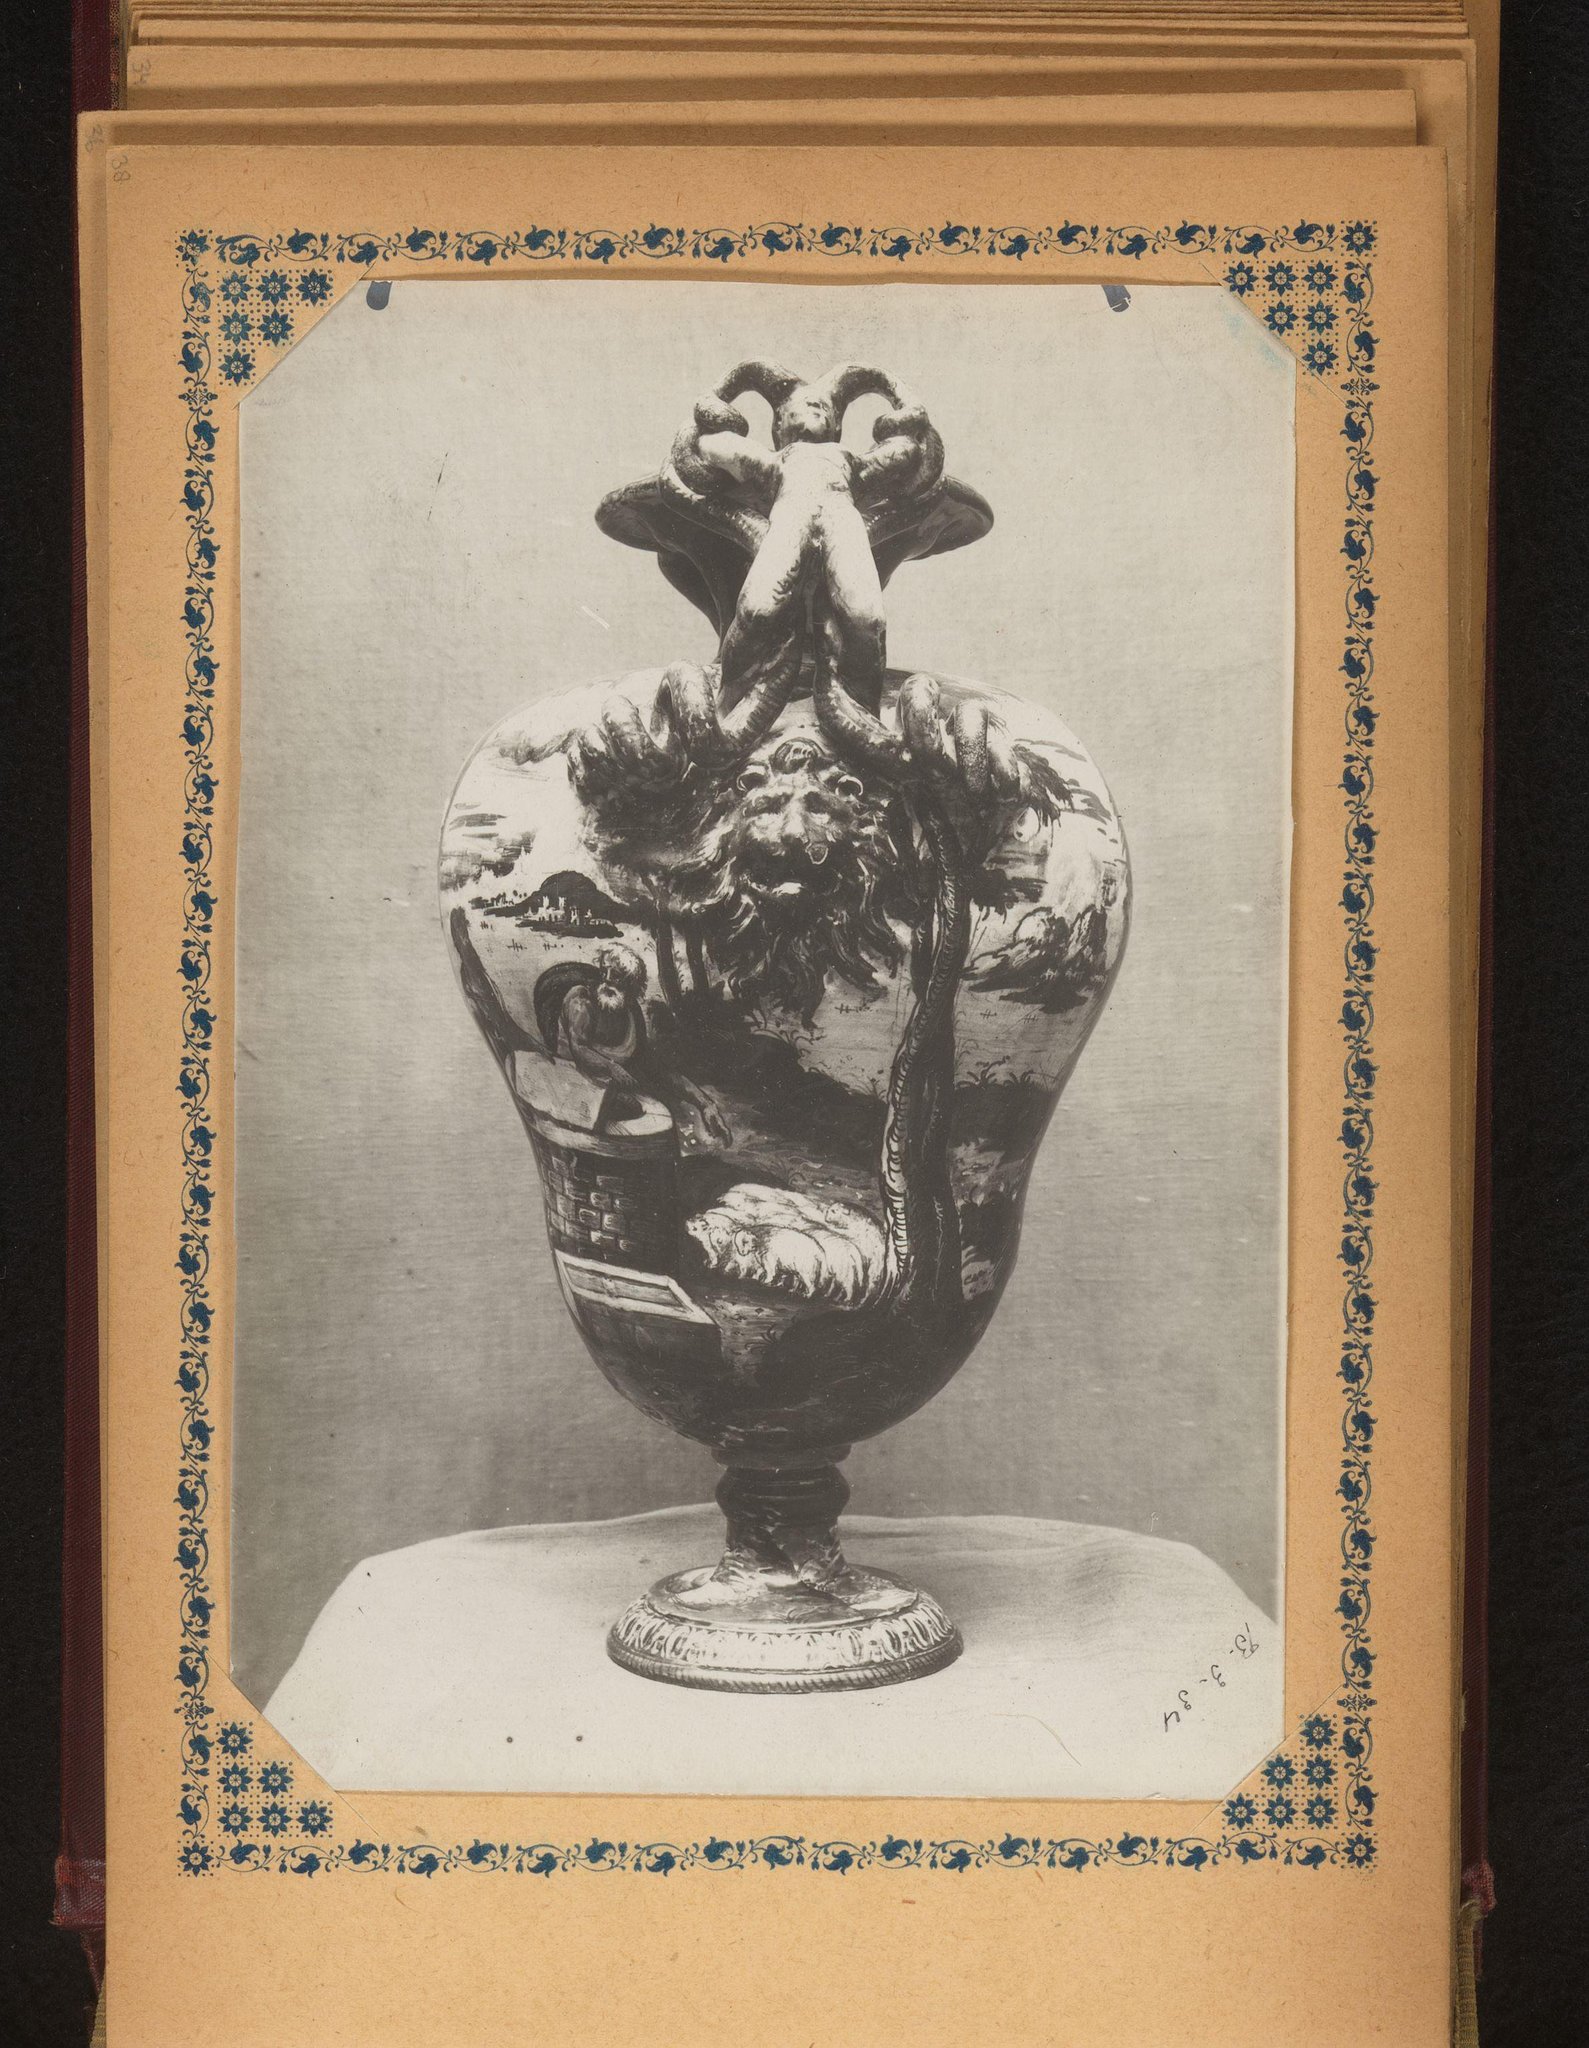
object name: album leaf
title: Vaas gedecoreerd met een leeuwenkop en beschilderd met figuren en dieren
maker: Anonymous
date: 1880-1940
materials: cardboard, photographic support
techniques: gelatin silver print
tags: lion's head ~ ornament, animals, the (nude) human figure; 'corpo humano' (ripa), container of ceramics: jar, jug, pot, vase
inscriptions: number: ‘B. 3. 34’